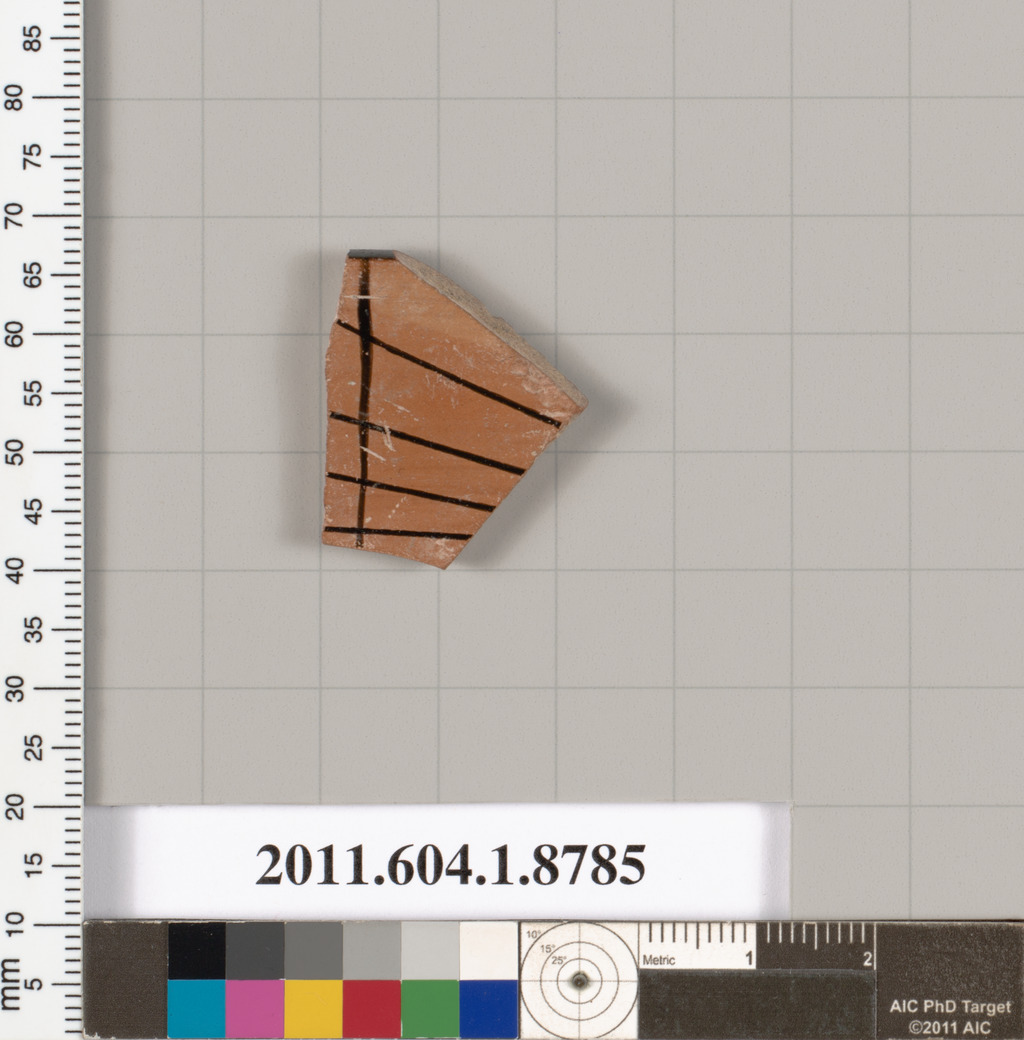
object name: kylix fragment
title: Terracotta rim fragment of a kylix (drinking cup)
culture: greek, attic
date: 480-460 BCE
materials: terracotta